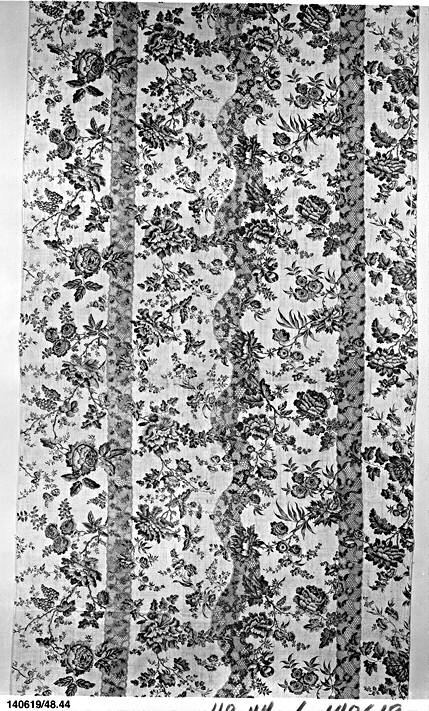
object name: piece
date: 1751-1775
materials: cotton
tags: flowers,leaves